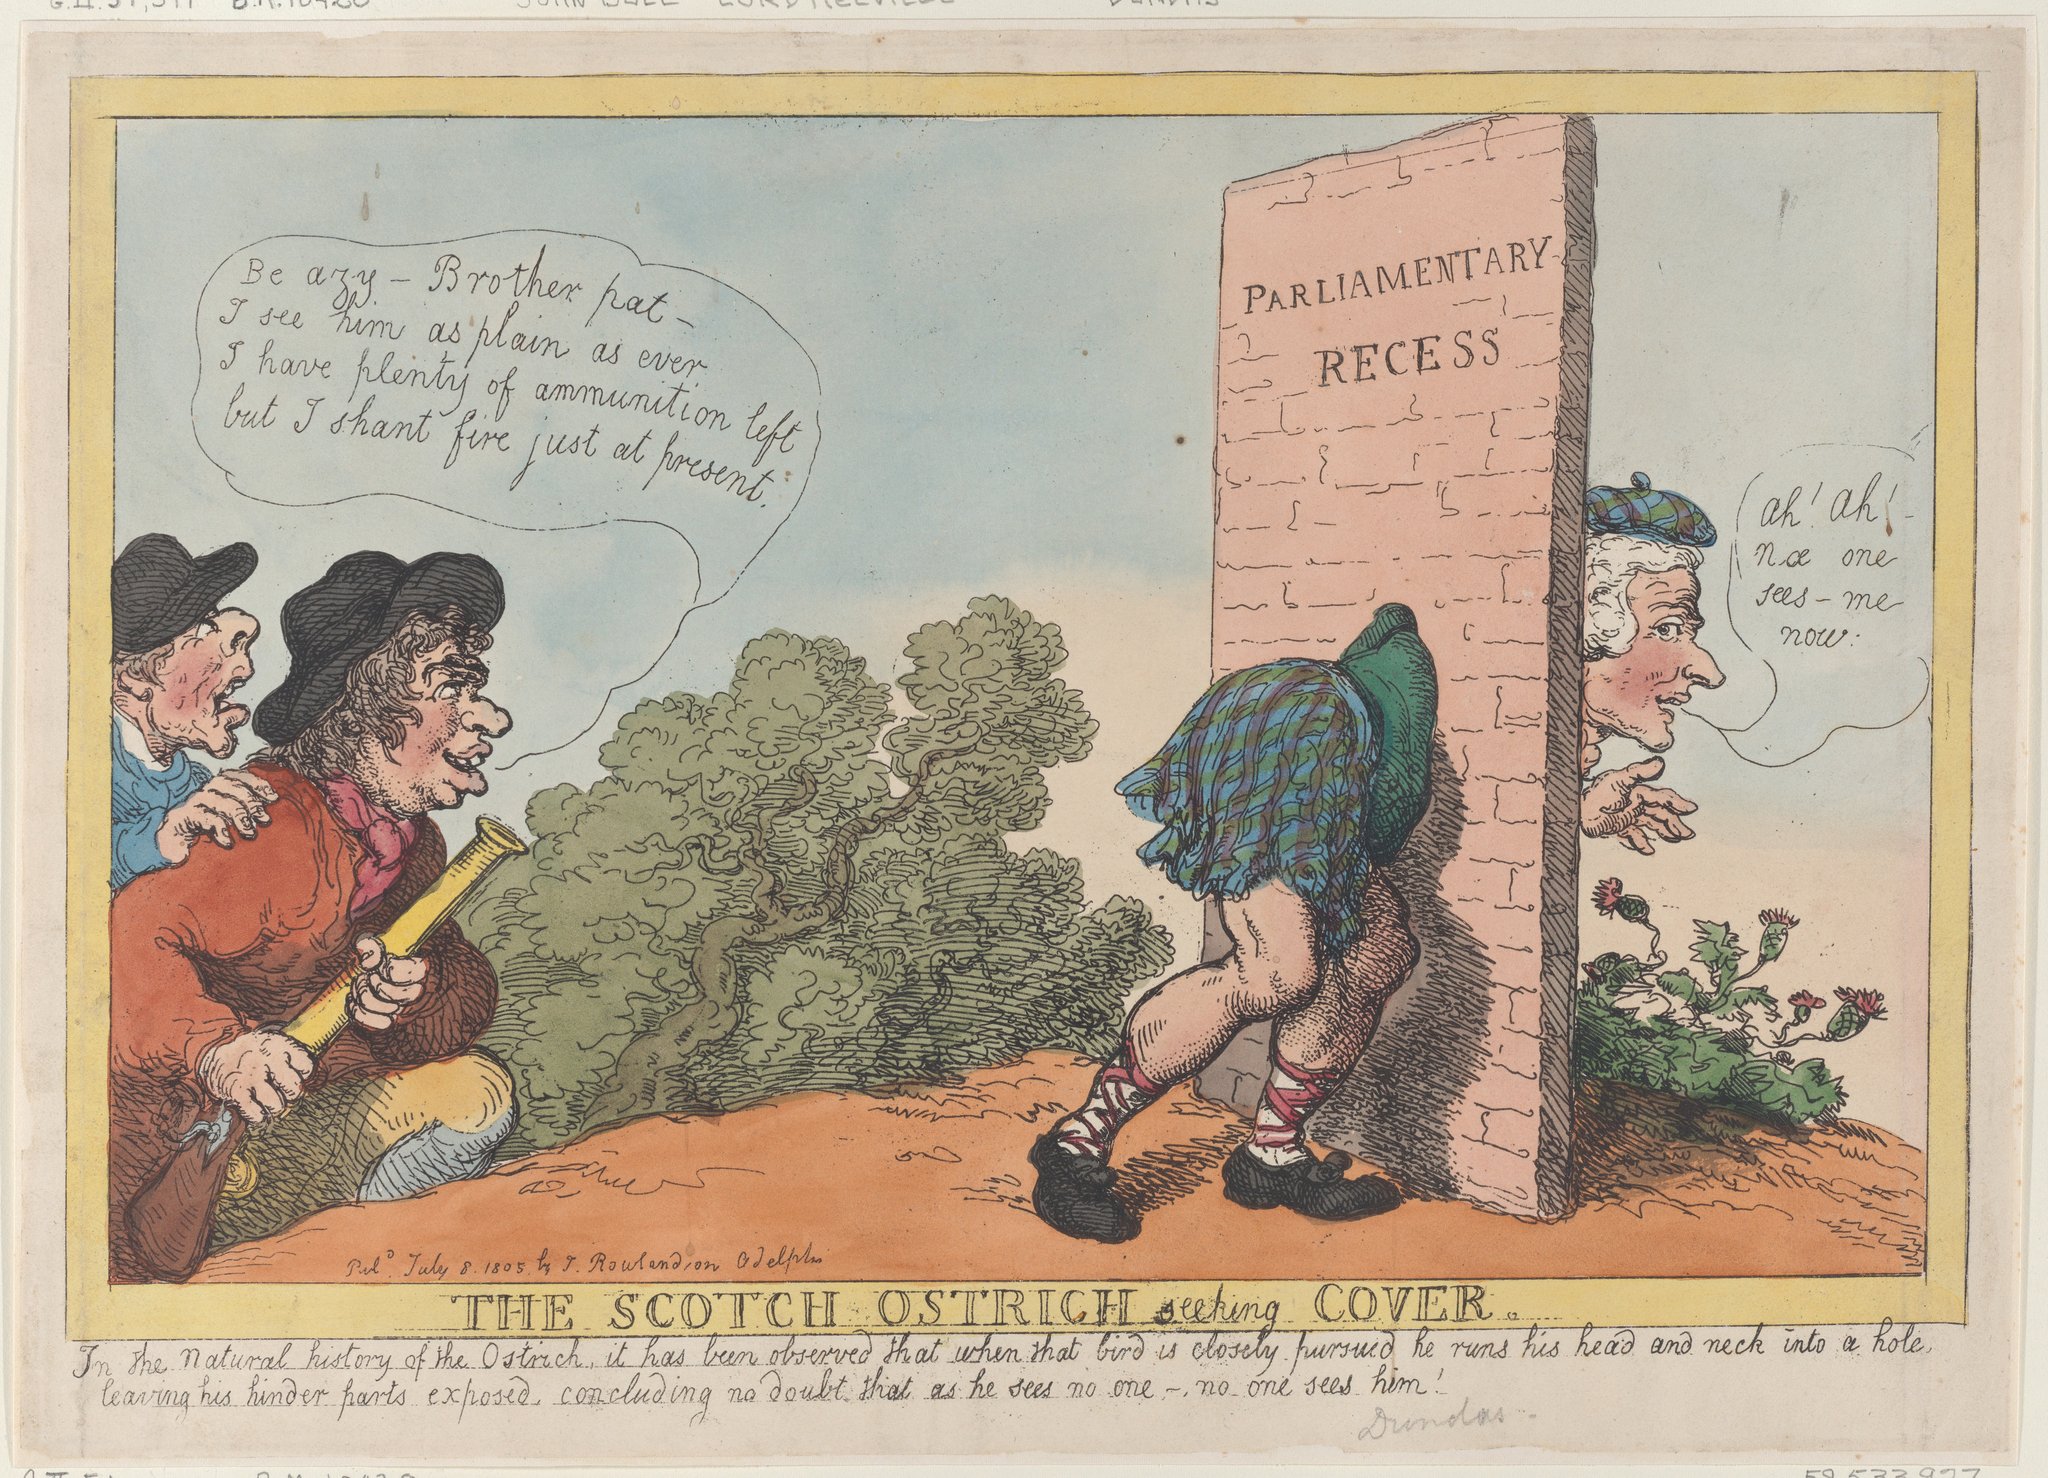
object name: print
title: The Scotch Ostrich Seeking Cover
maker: thomas rowlandson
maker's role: artist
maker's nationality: british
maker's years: 1757-1827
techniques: etching